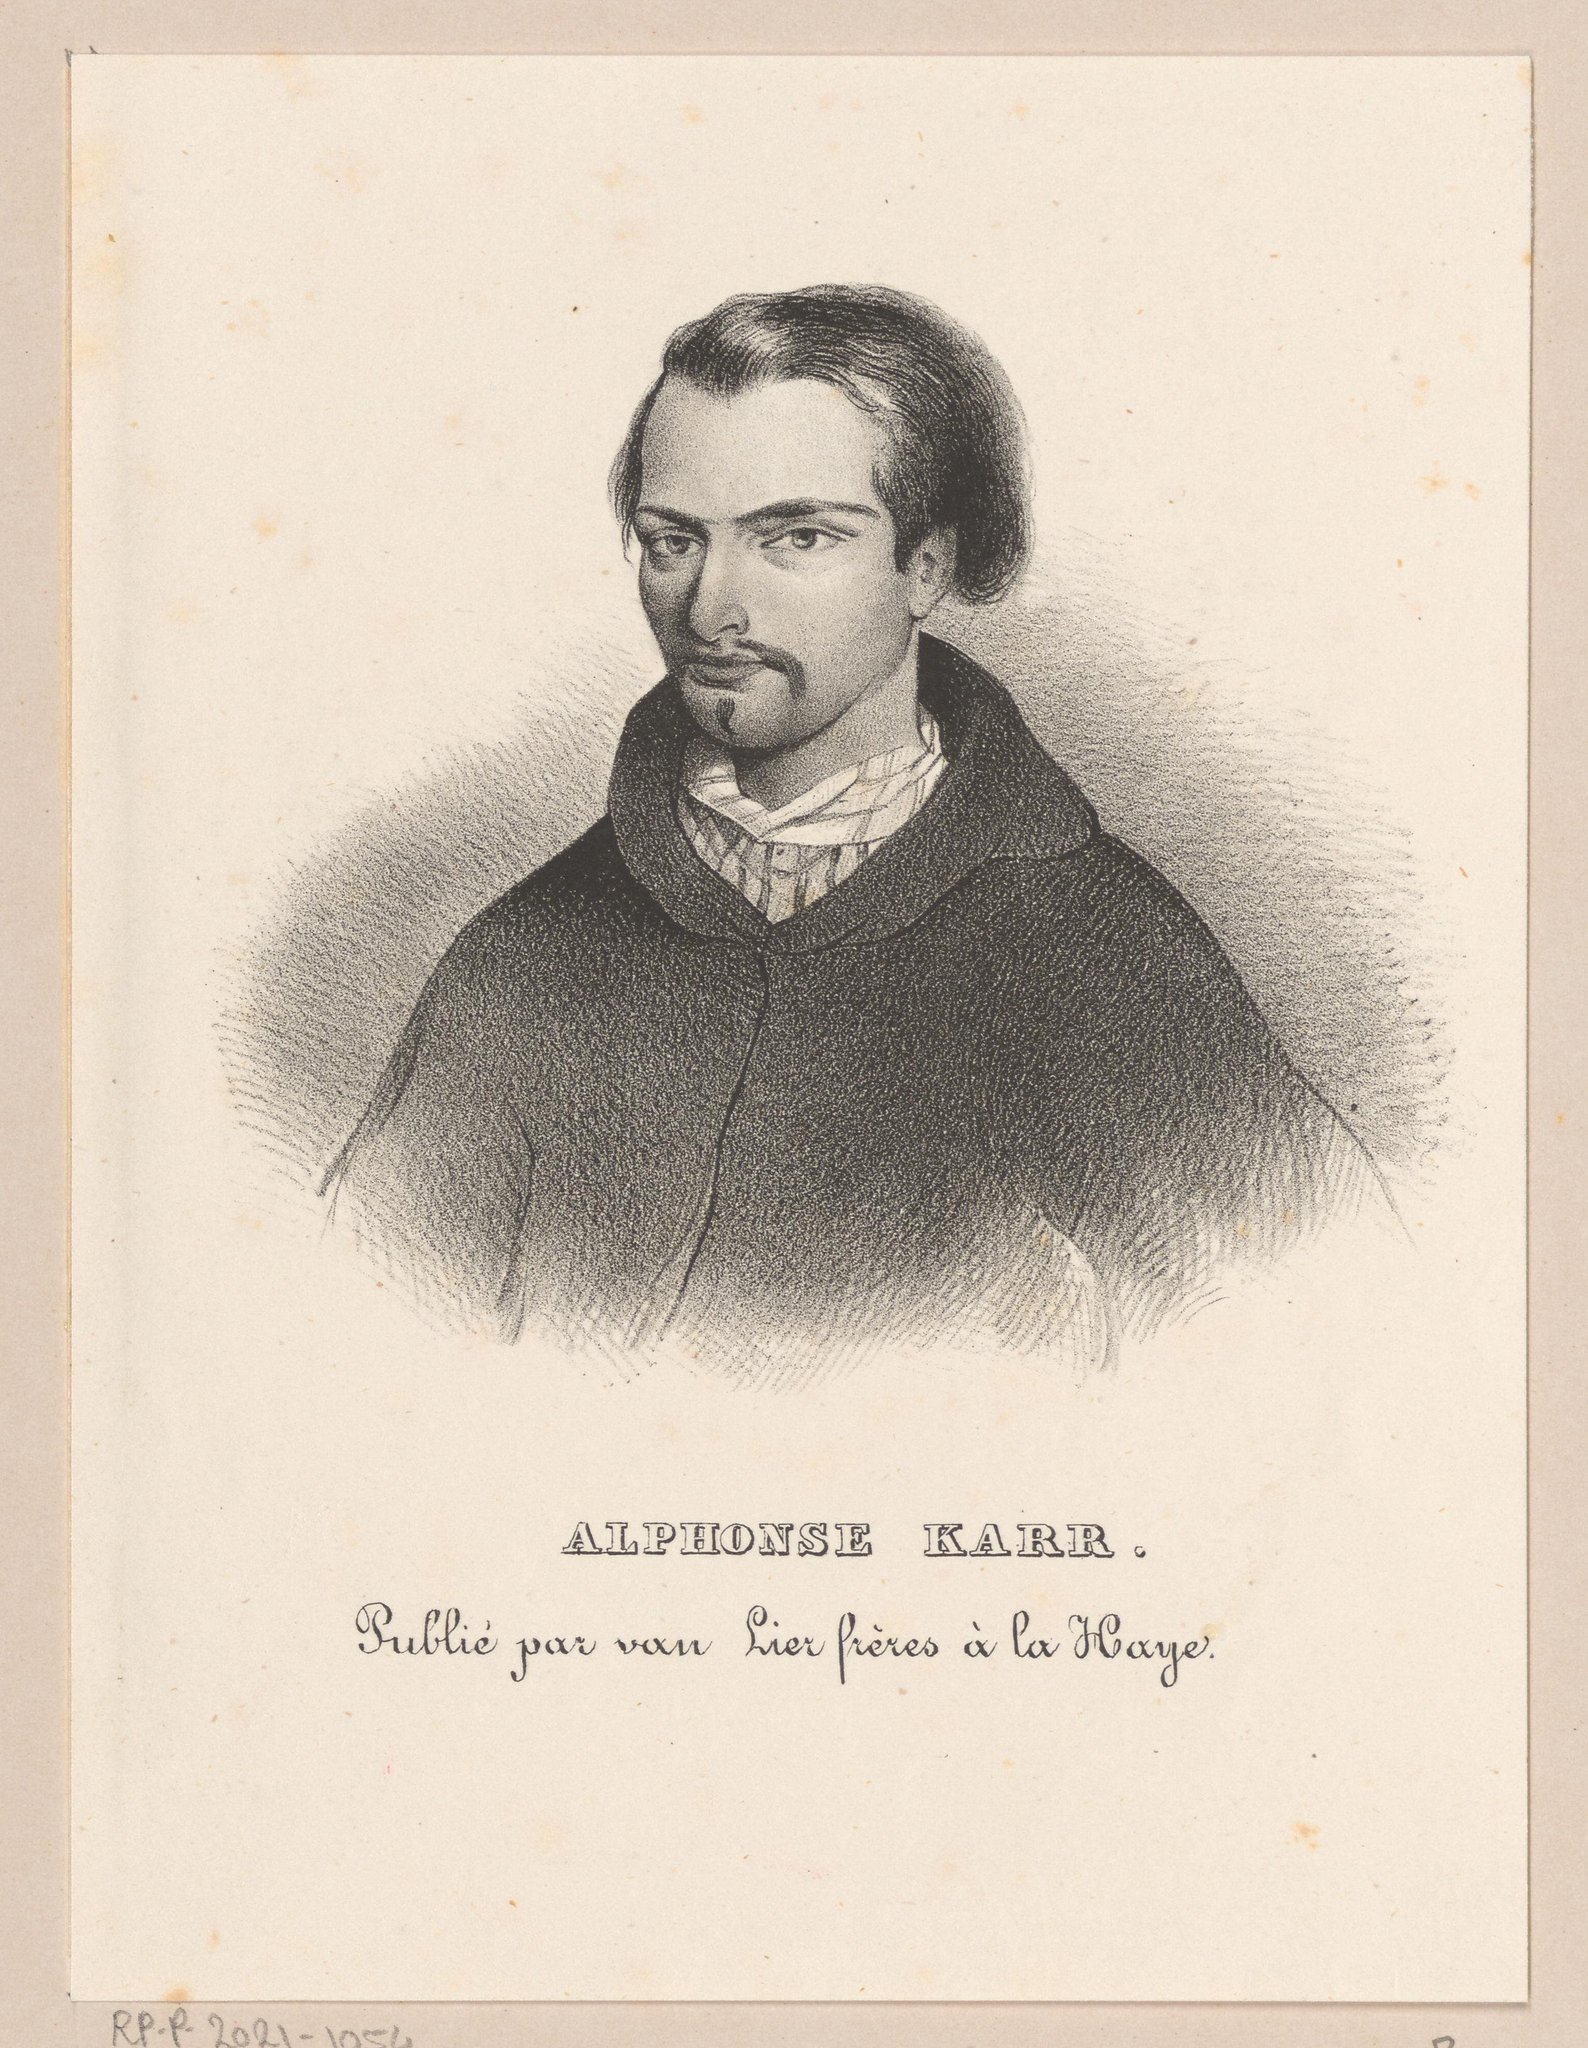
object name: print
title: Portret van Alphonse Karr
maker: Anonymous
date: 1833-1846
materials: paper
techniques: lithograph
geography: the hague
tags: paris, alphonse karr, historical persons, portrait of a writer